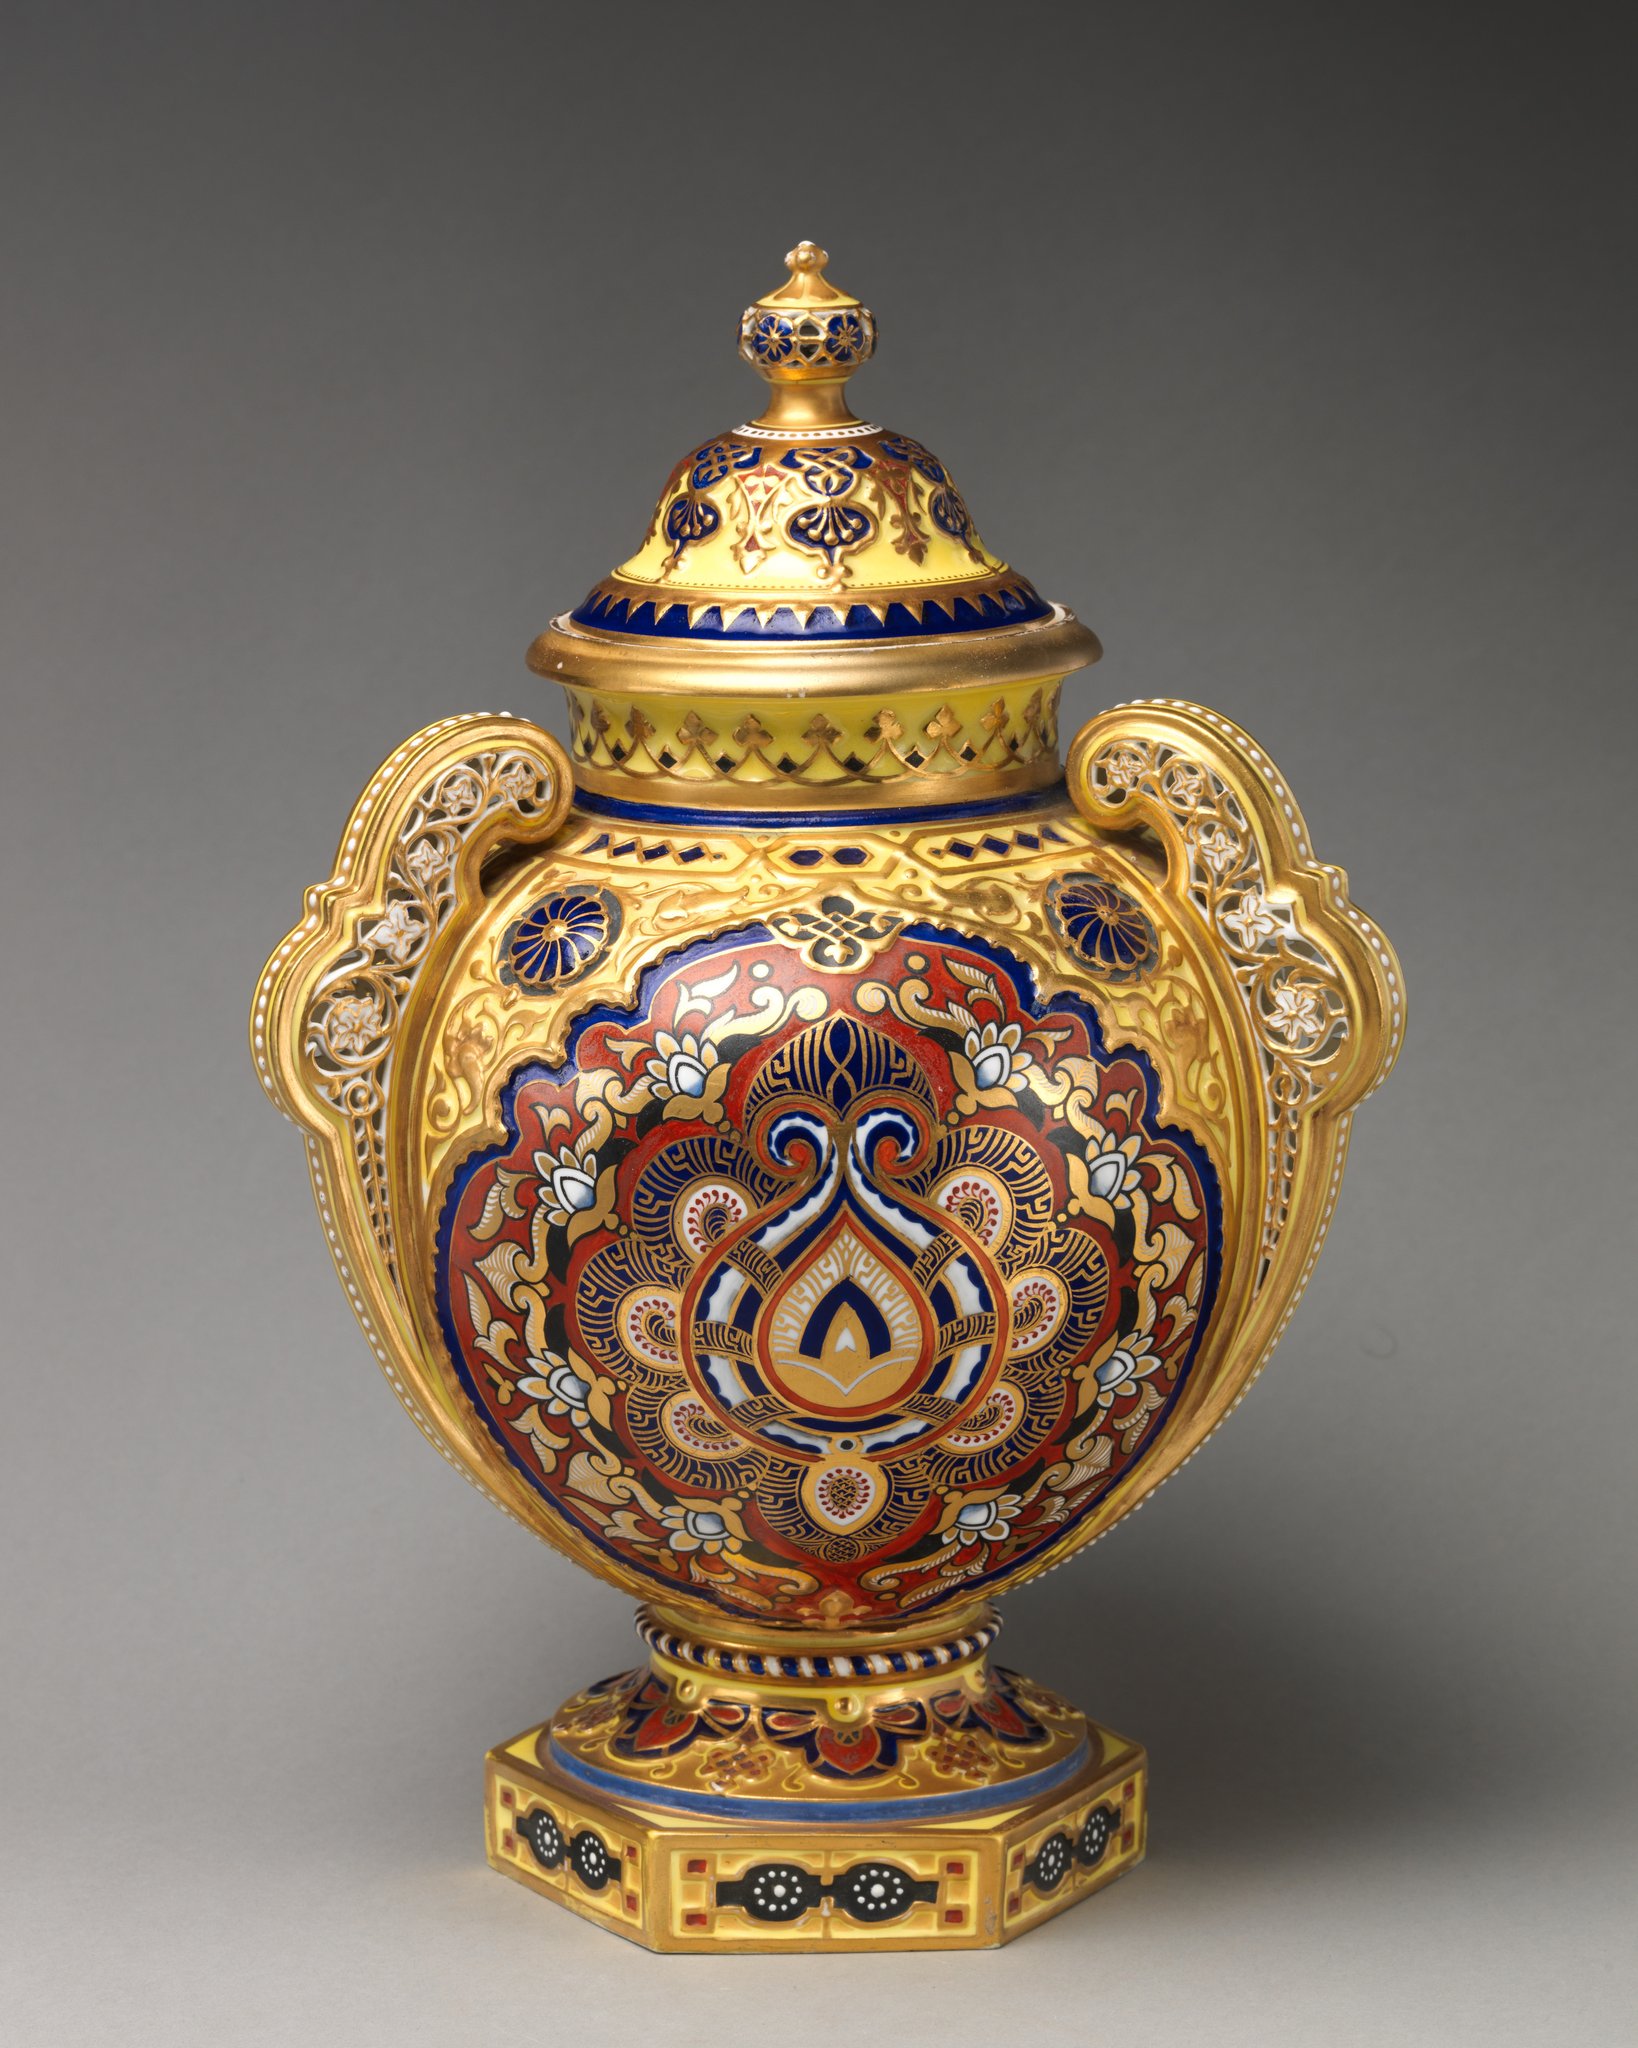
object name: lidded jar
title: "Alhambra" vase with lid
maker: crown derby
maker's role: maker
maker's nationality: british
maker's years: 1750-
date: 1877-1890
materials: bone china, enamel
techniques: gilding